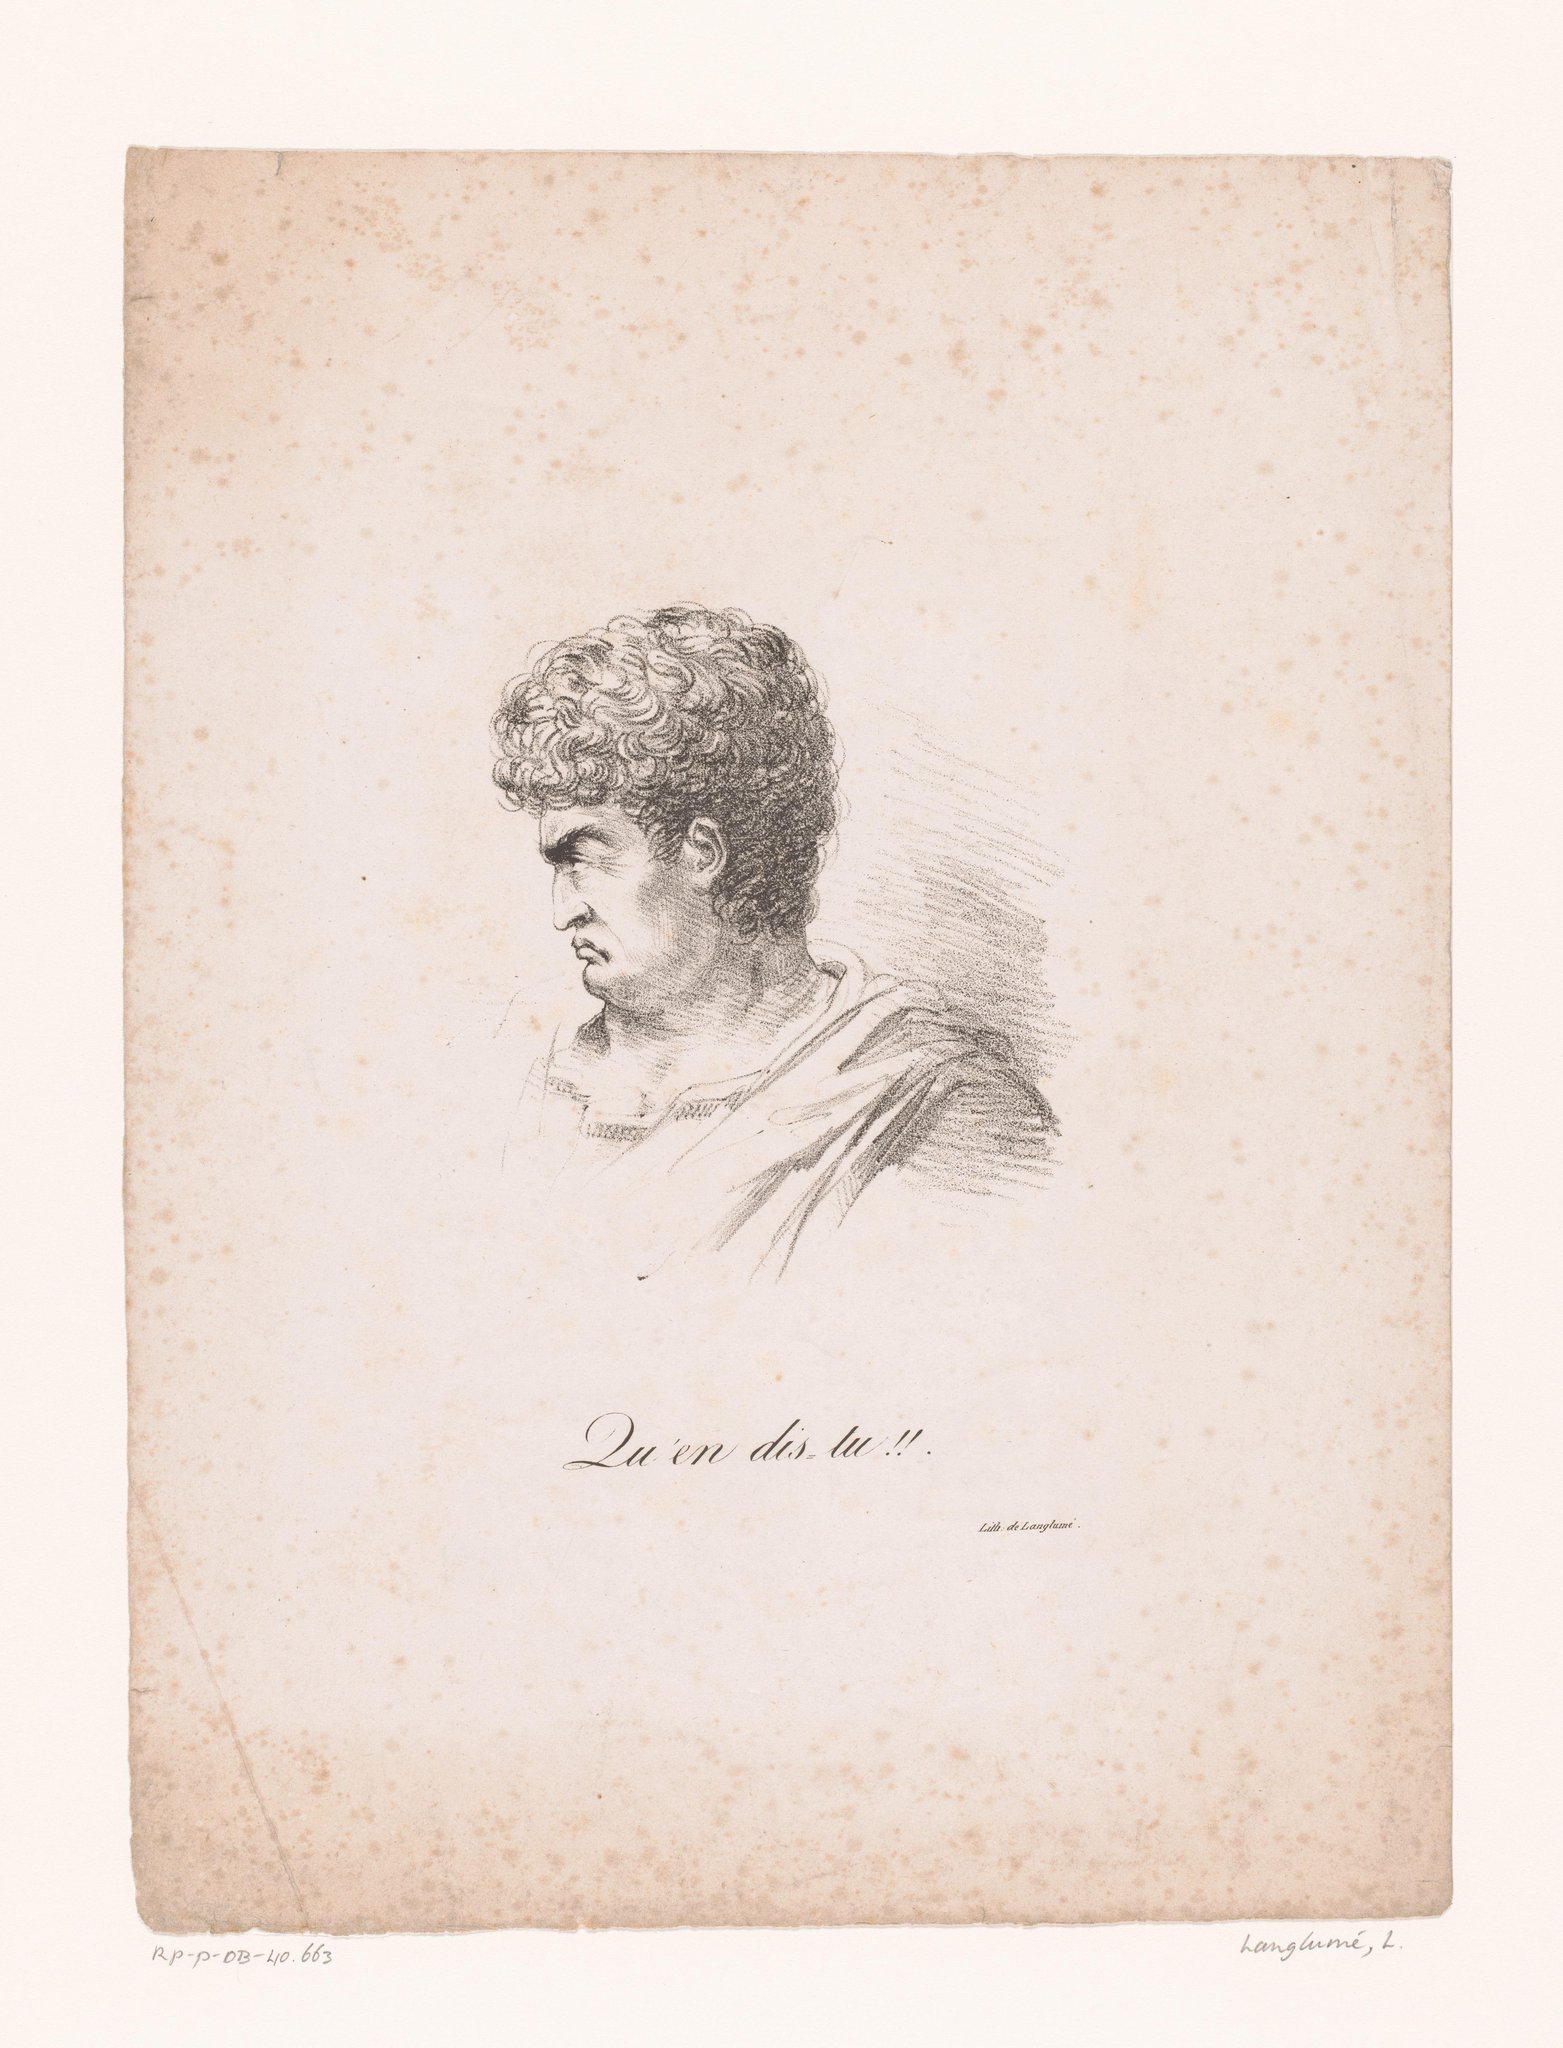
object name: print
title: Hoofd van een fronsende man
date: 1820-1830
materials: paper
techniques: lithograph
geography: paris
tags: frowned eyebrows, adult man (+ sideview, profile)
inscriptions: collector's mark: Lugt 2166